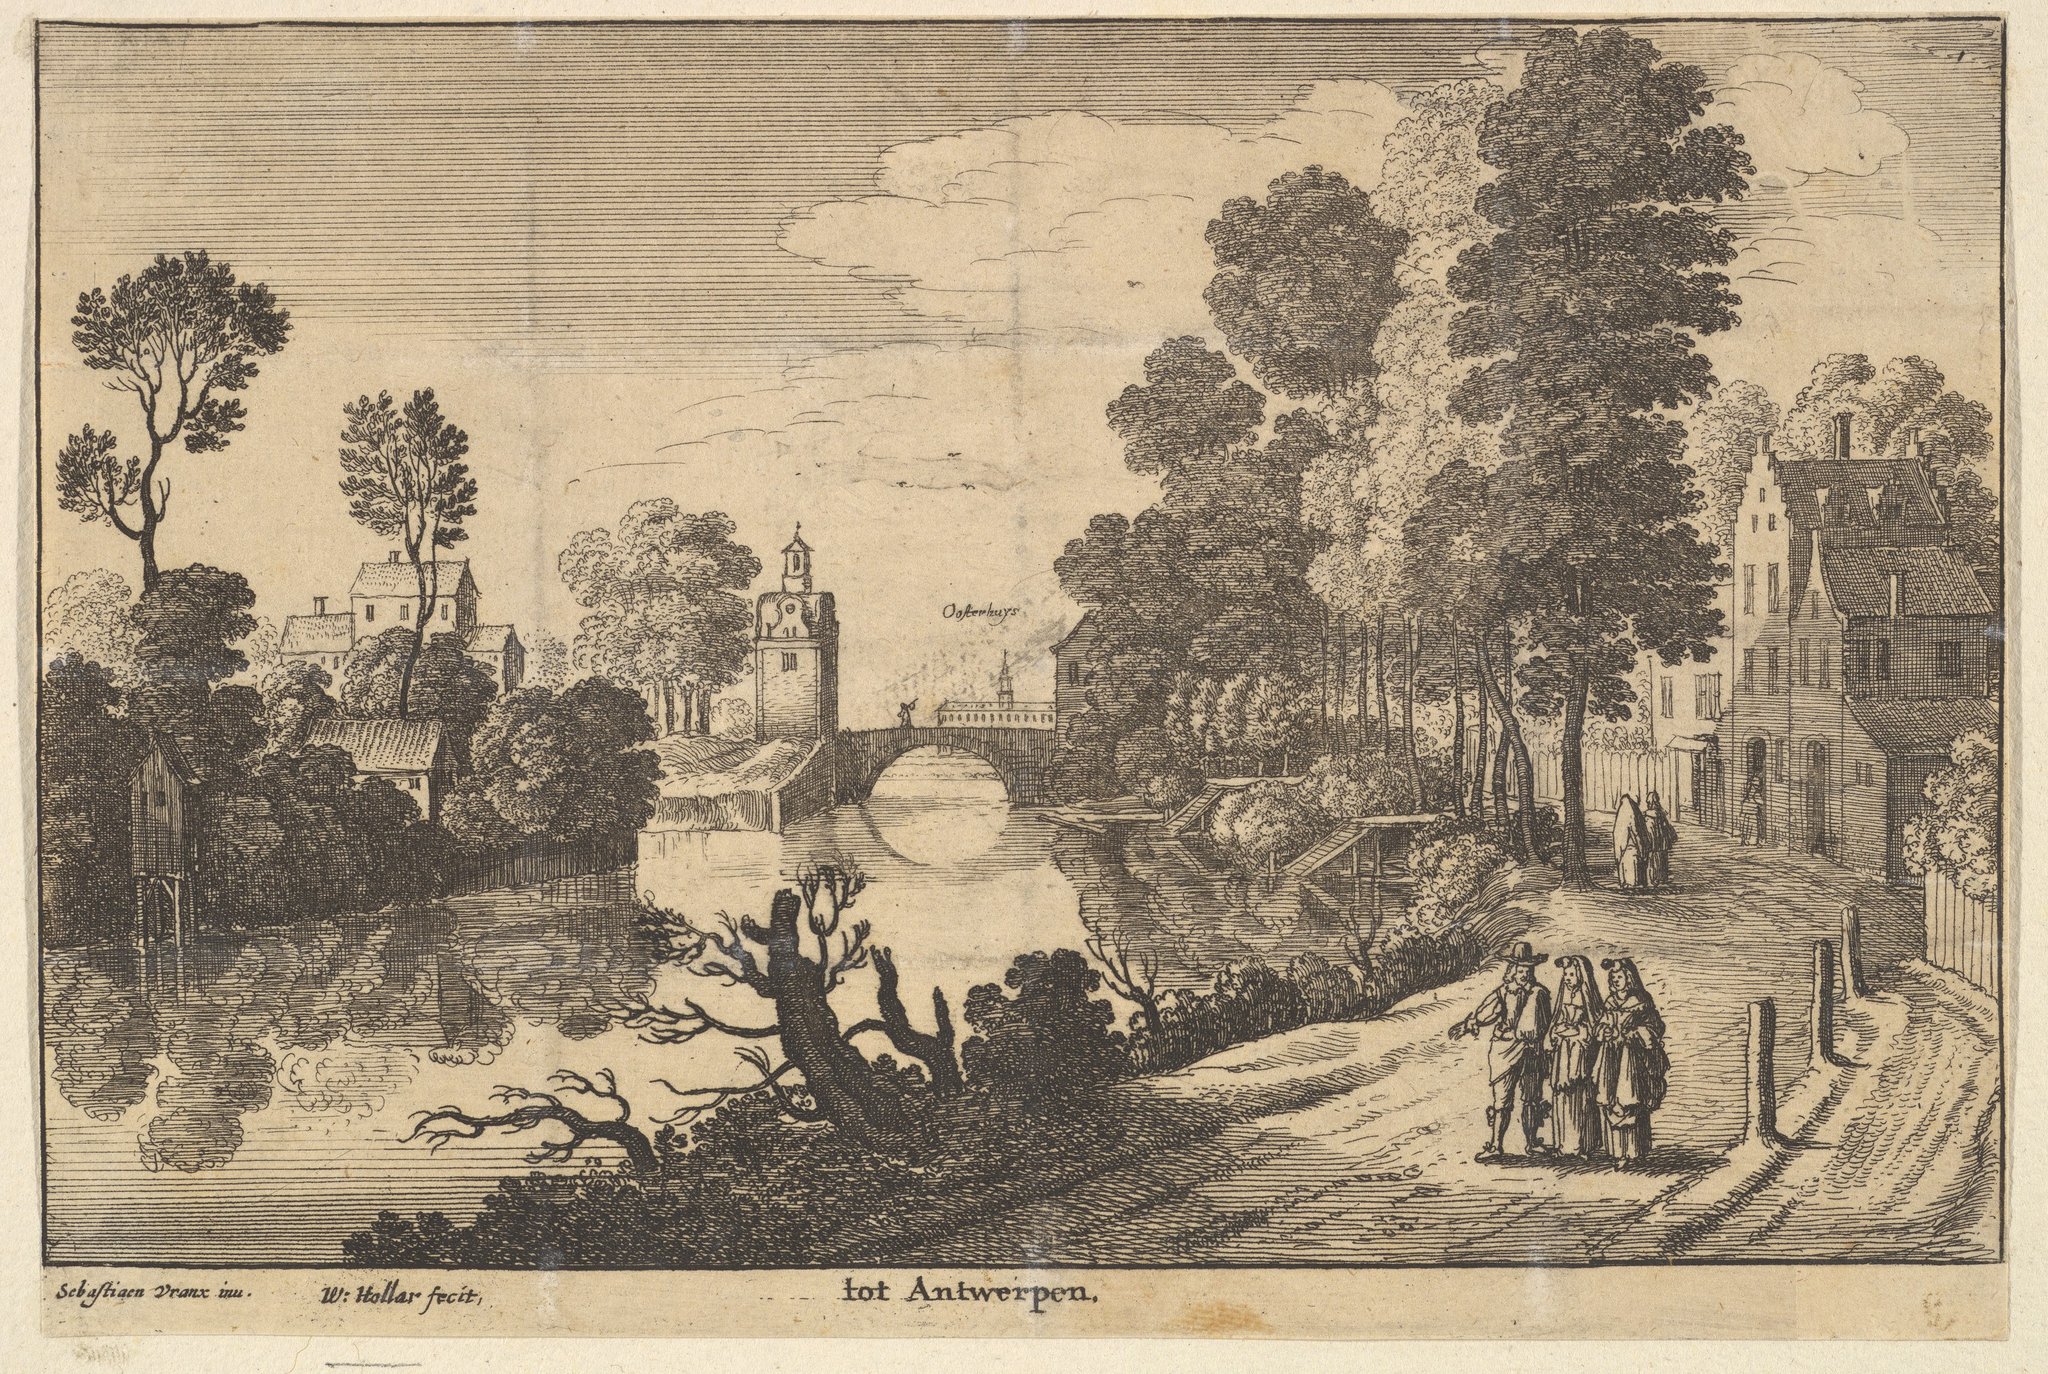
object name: print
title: Antwerp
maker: wenceslaus hollar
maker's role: artist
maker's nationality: bohemian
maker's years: 1607-1677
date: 1625-1677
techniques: etching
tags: bridges,rivers,landscapes